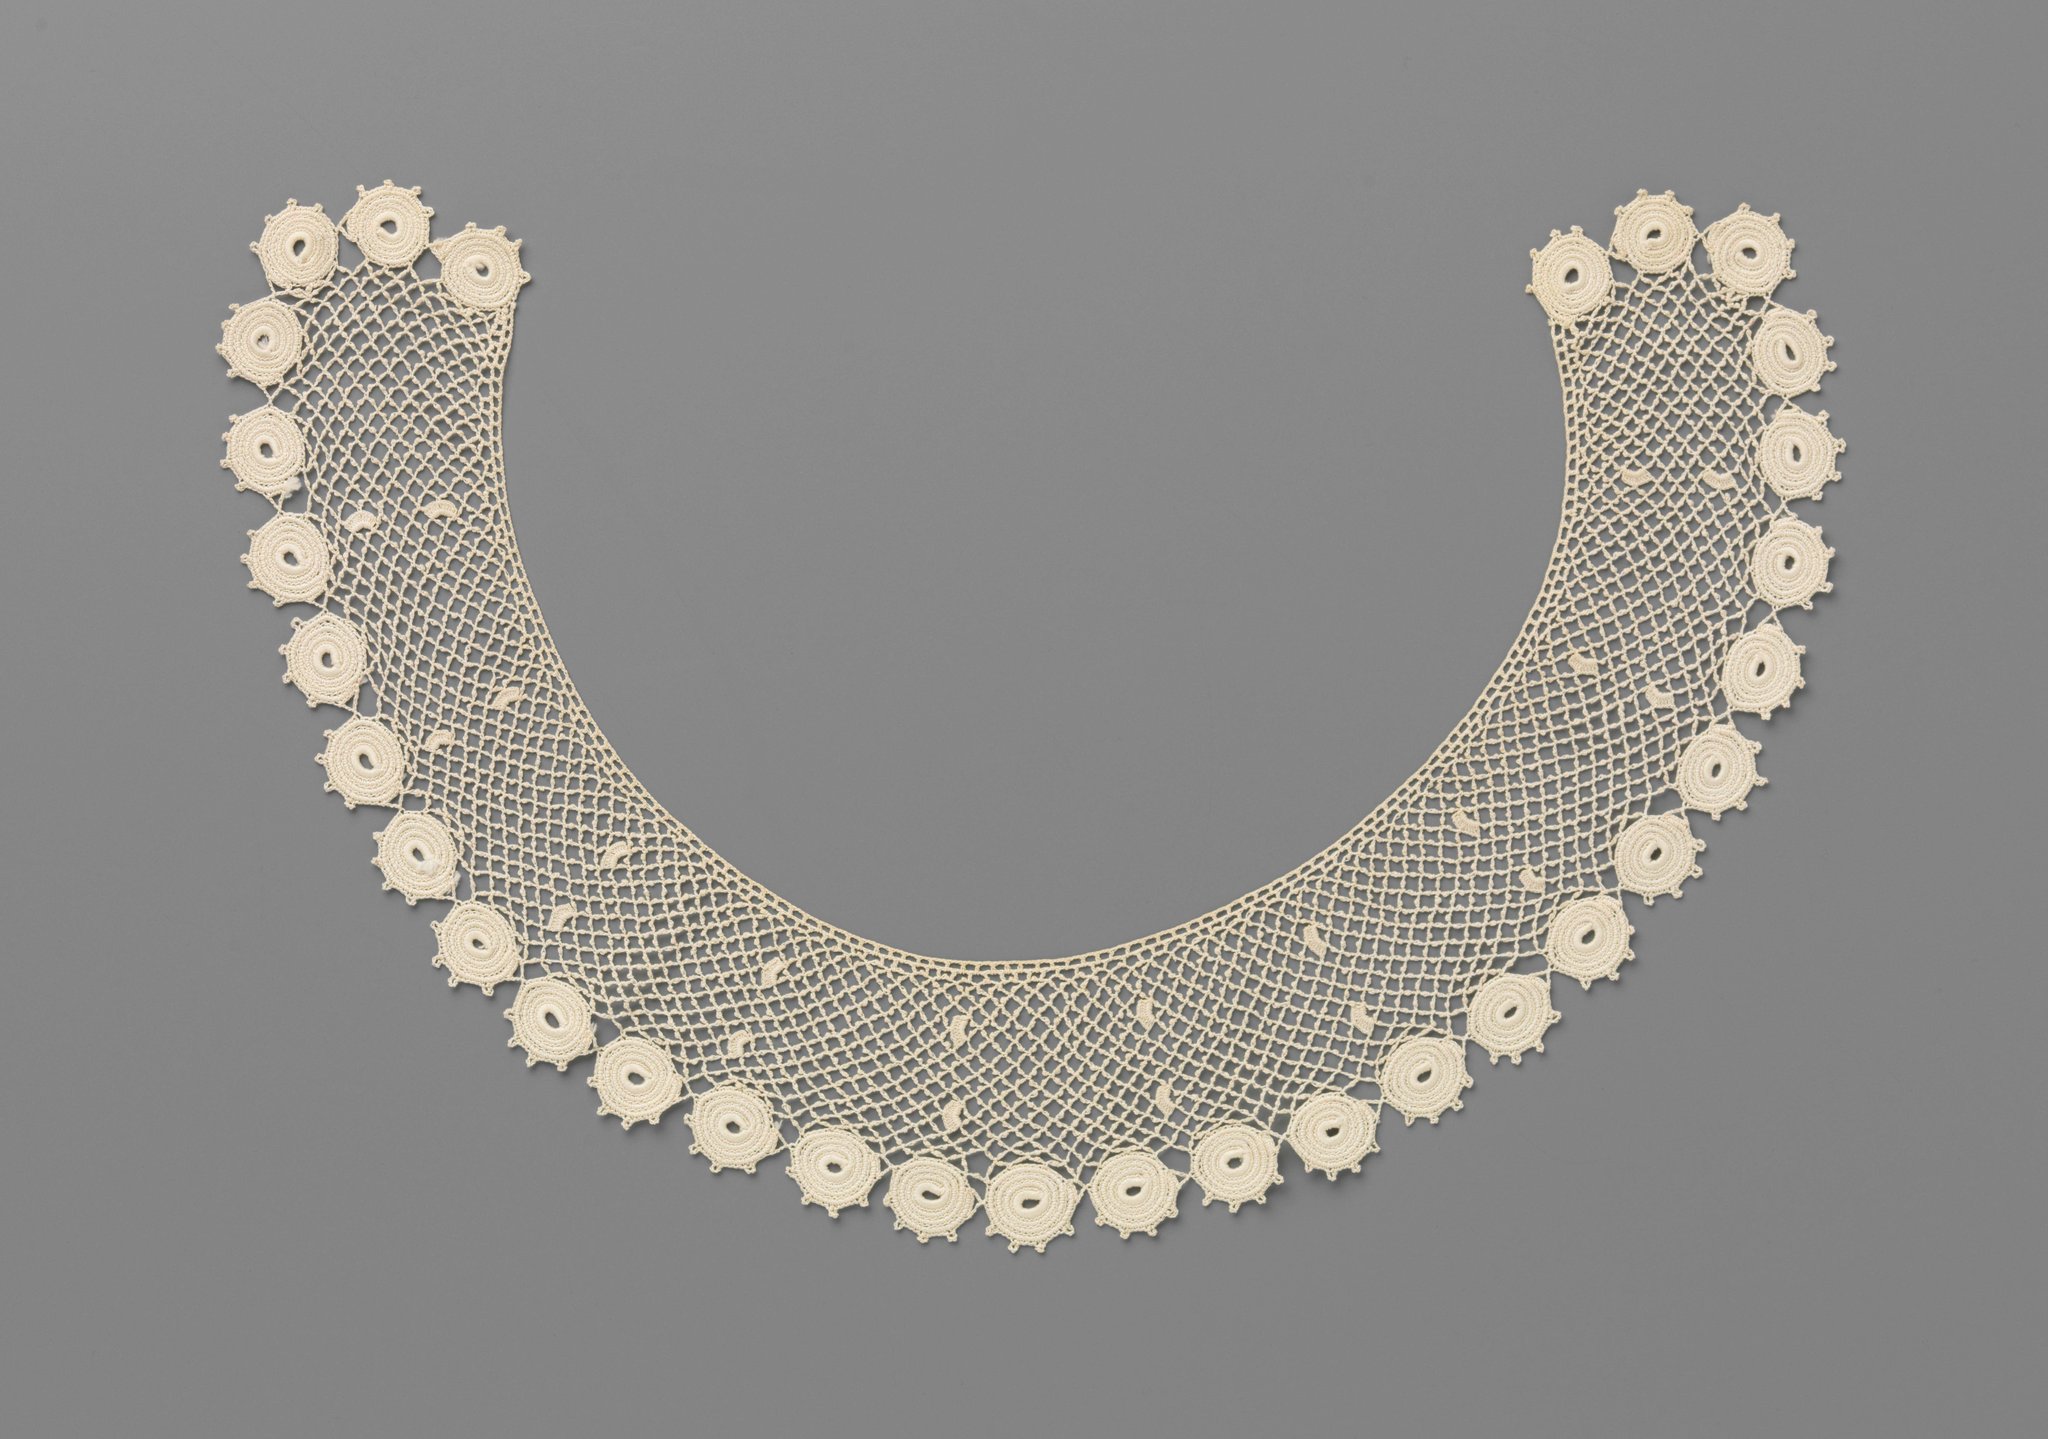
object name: collar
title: Kraag van gehaakte kant met ronde spiraalschulpen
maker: Anonymous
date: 1930-1935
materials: cotton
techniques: crocheted lace, irish crochet lace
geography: amsterdam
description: Kraag van naturelkleurige Ierse gehaakte kant. Strookvormig rond model, 2/3 van een cirkel. Twee rijen moesjes, licht gebogen rechthoekjes in een ruitvormig netwerk met picots. Aan drie zijden afgewerkt met een schulpenrand van aaneengeschakelde ronde spiraalschulpen, die worden gevormd door een rondgelegde en omgehaakte draadbundel. De binnenrand is recht afgewerkt.